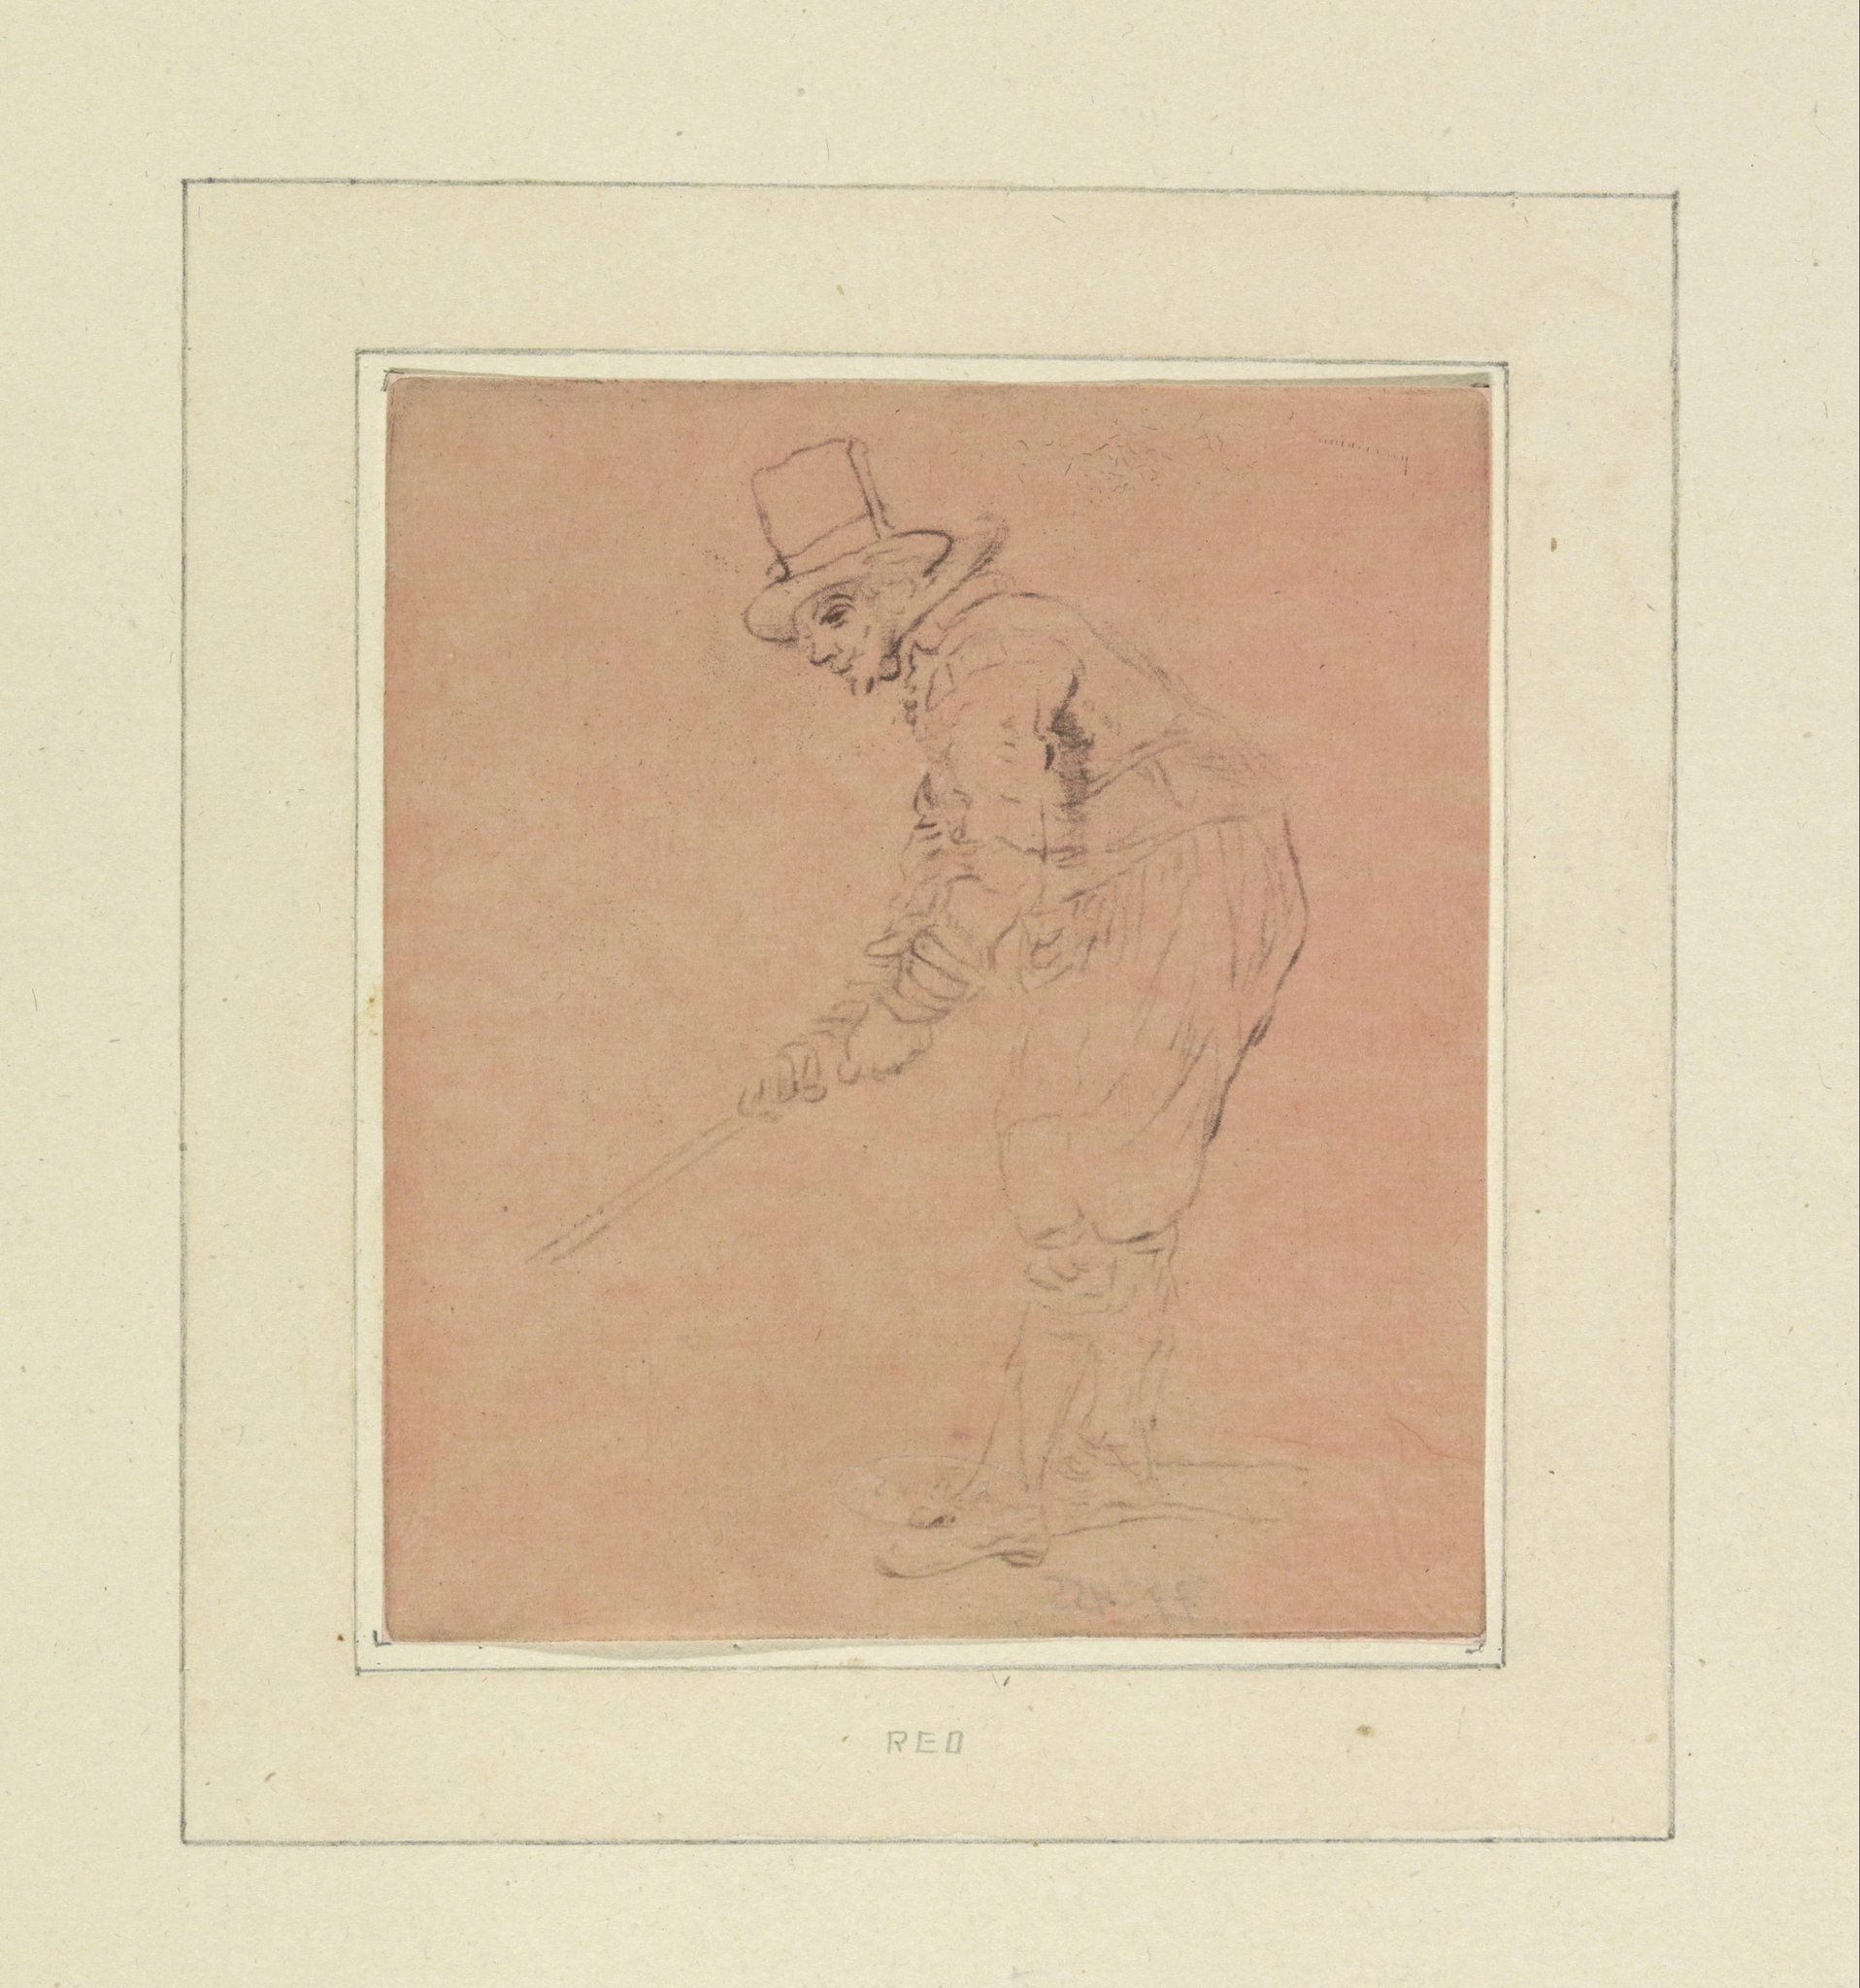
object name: print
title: Kolfspeler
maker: christiaan josi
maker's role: draughtsman, print maker, publisher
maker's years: 1765-1828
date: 1795-1828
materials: paper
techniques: printmaking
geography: amsterdam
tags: 'kolf' (ball game) (+ sportsman, player, etc.)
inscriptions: collector's mark: Lugt 2228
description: Een man met hoge hoed staat gebogen over een kolfstok in zijn handen.